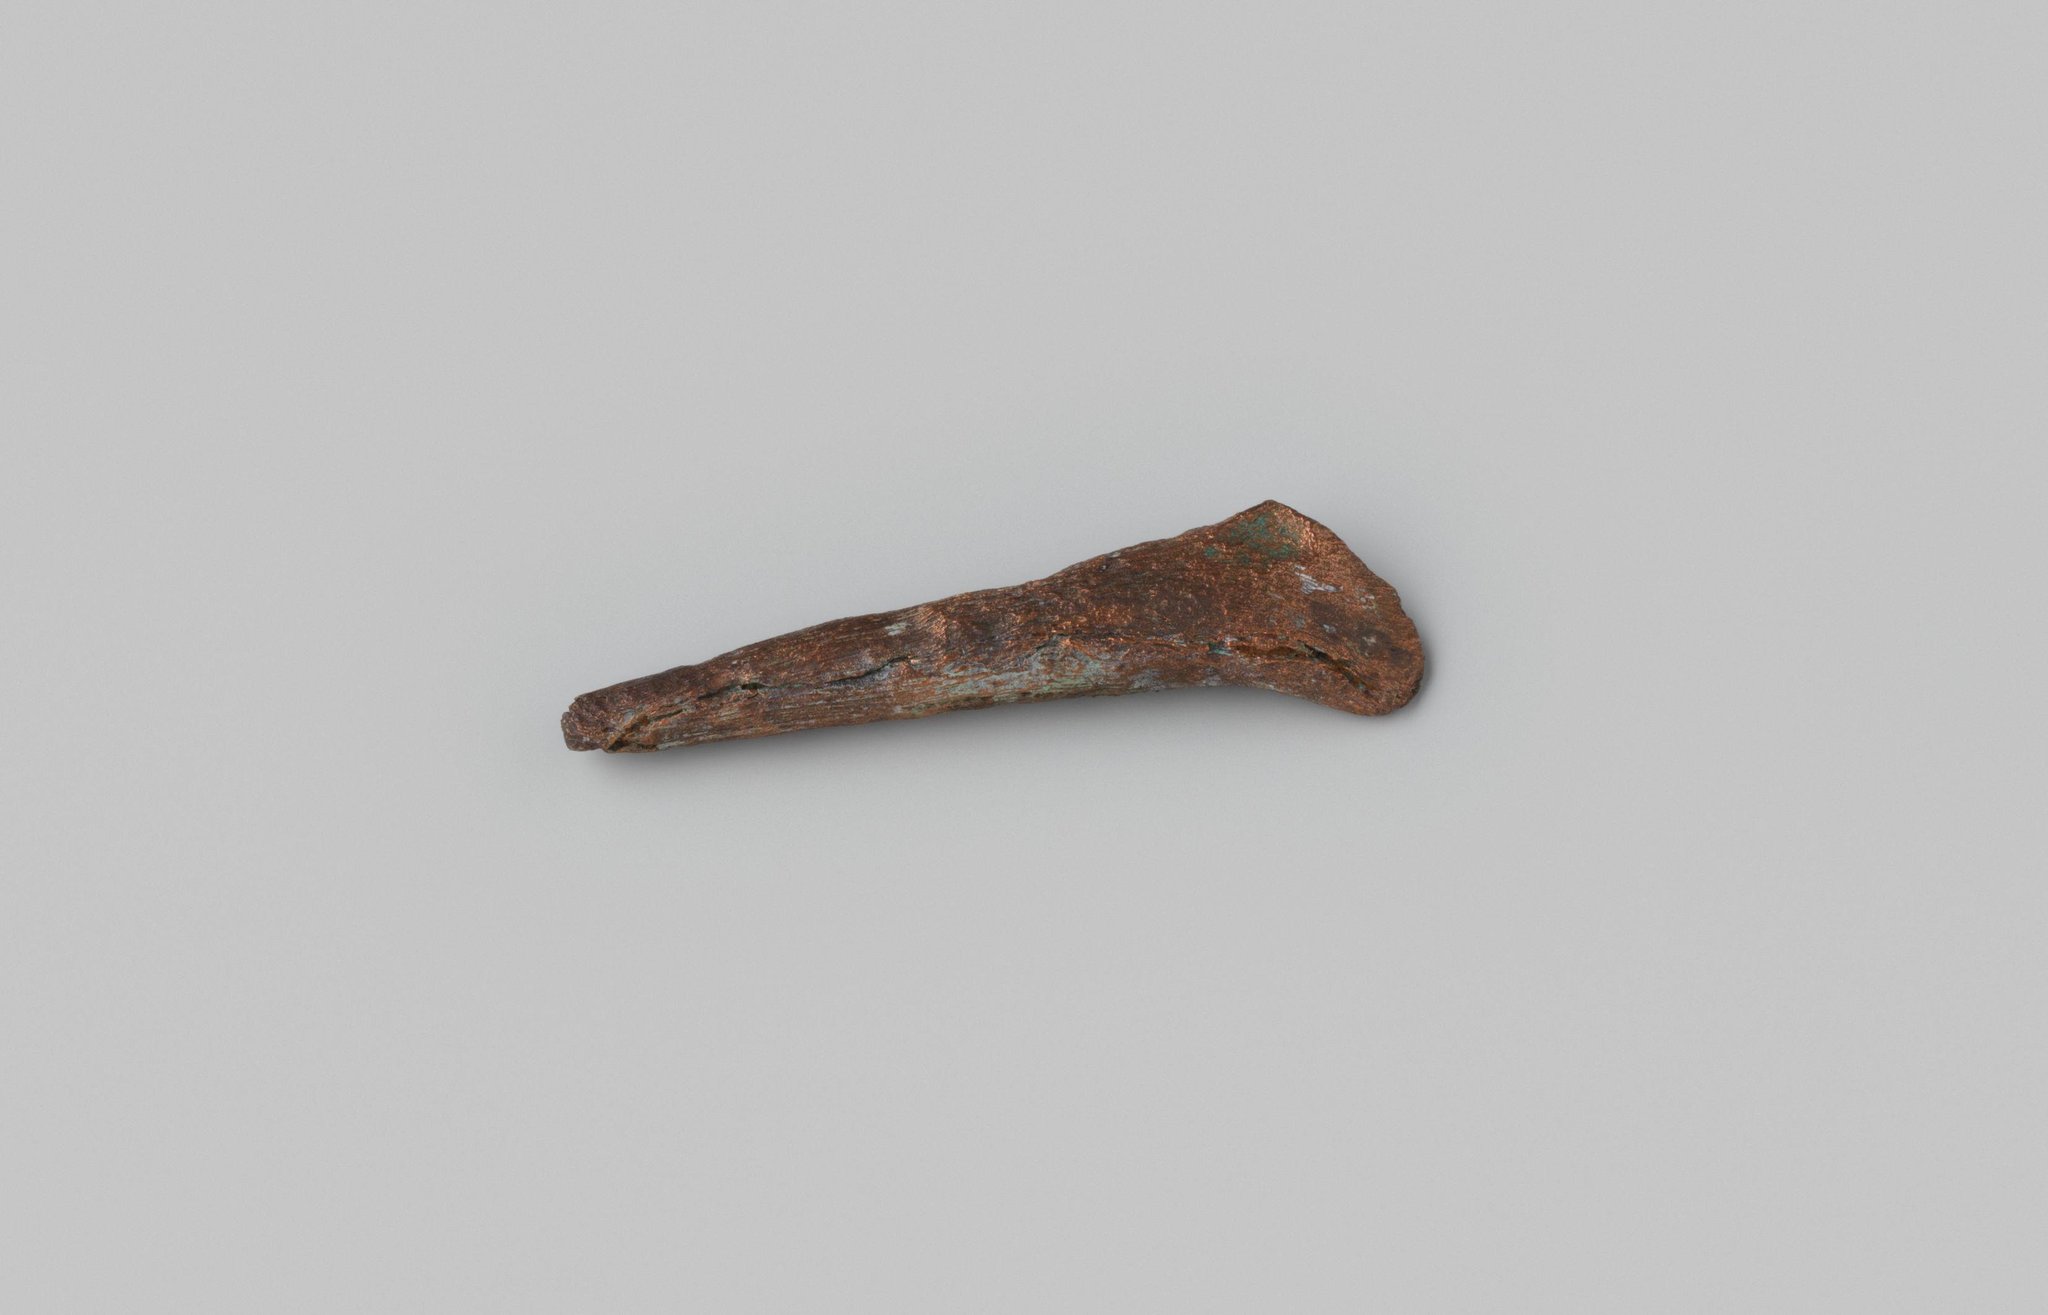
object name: wedge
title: Wig uit het wrak van de Oost-Indiëvaarder Hollandia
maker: Anonymous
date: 1700-1743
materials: copper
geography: netherlands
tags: verenigde oostindische compagnie, hollandia (schip), annet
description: Locks, fastenings and accesories, wedge; id. NG 1980-27H1492, eroded.